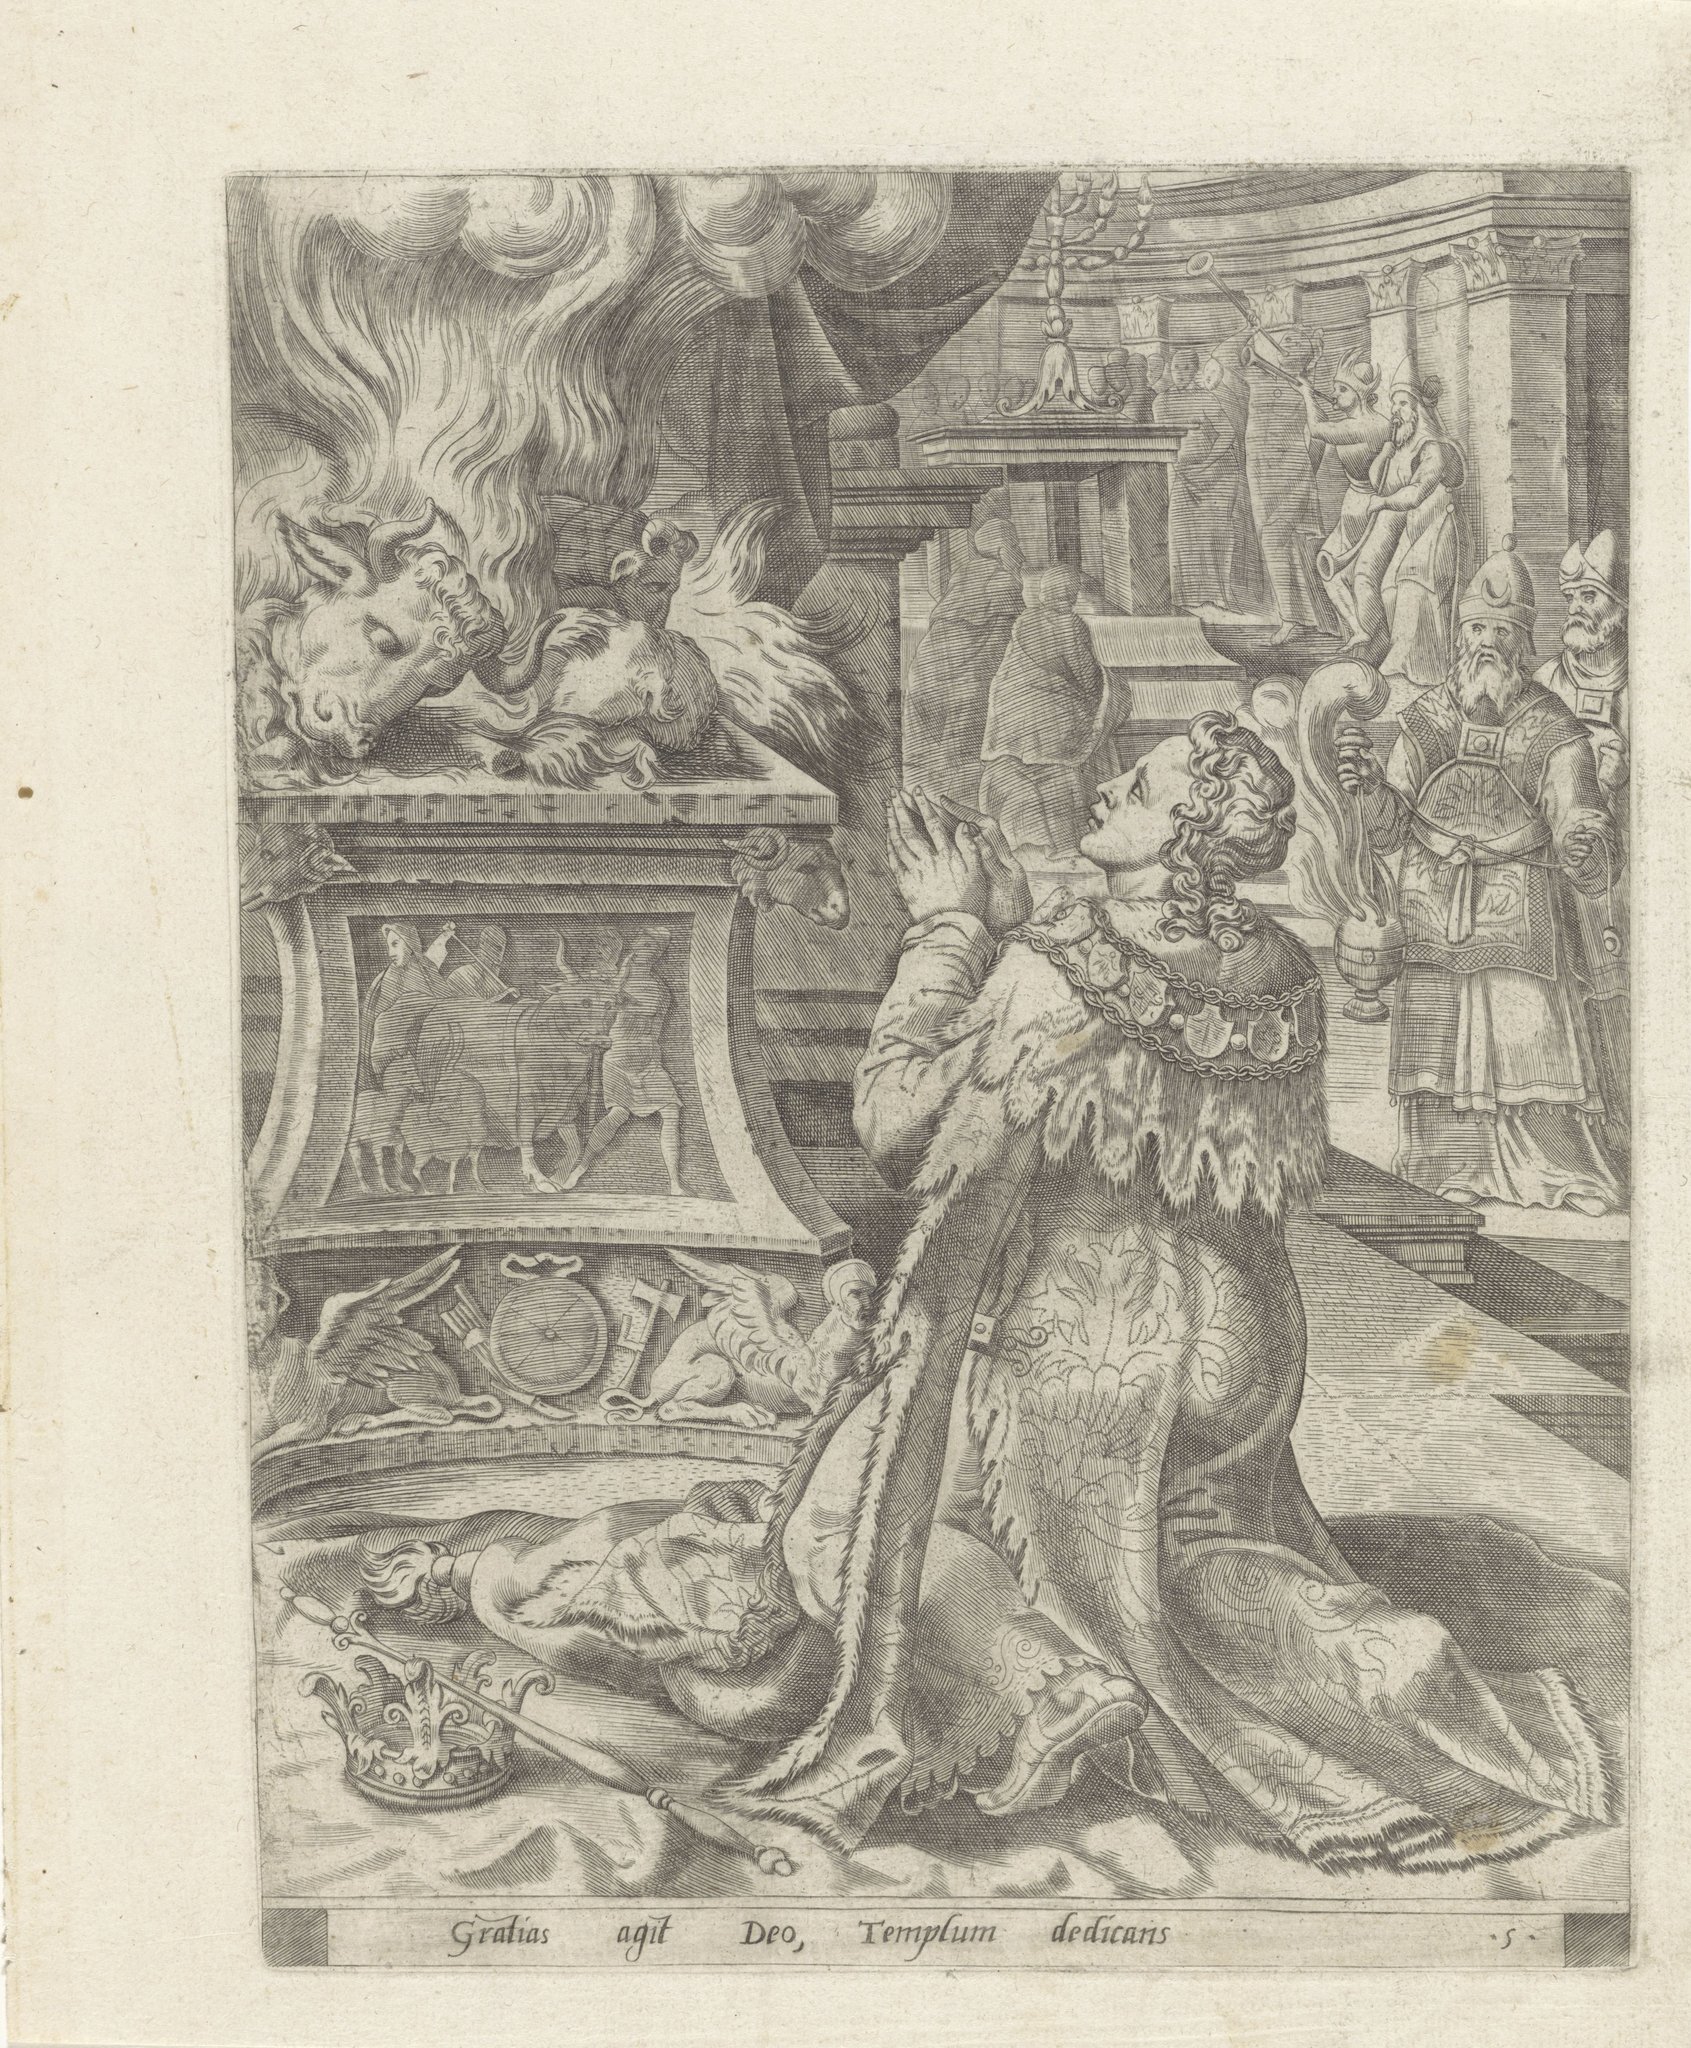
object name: print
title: Verhaal van Salomo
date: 1554-1595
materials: paper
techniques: engraving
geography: antwerp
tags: sacrificial feast in solomon's temple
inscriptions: collector's mark: Lugt 2228, collector's mark: Lugt 2760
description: Salomon knielt in een tempel om God voor de tempel te bedanken. Voor hem een offeraltaar waarop een ram en een koeienkop. Naast hem liggen zijn kroon en scepter. Op de achtergrond een priester met een wierookvat en enkele figuren met een bazuin. Onderaan in de marge een éénregelig onderschrift in het Latijn.